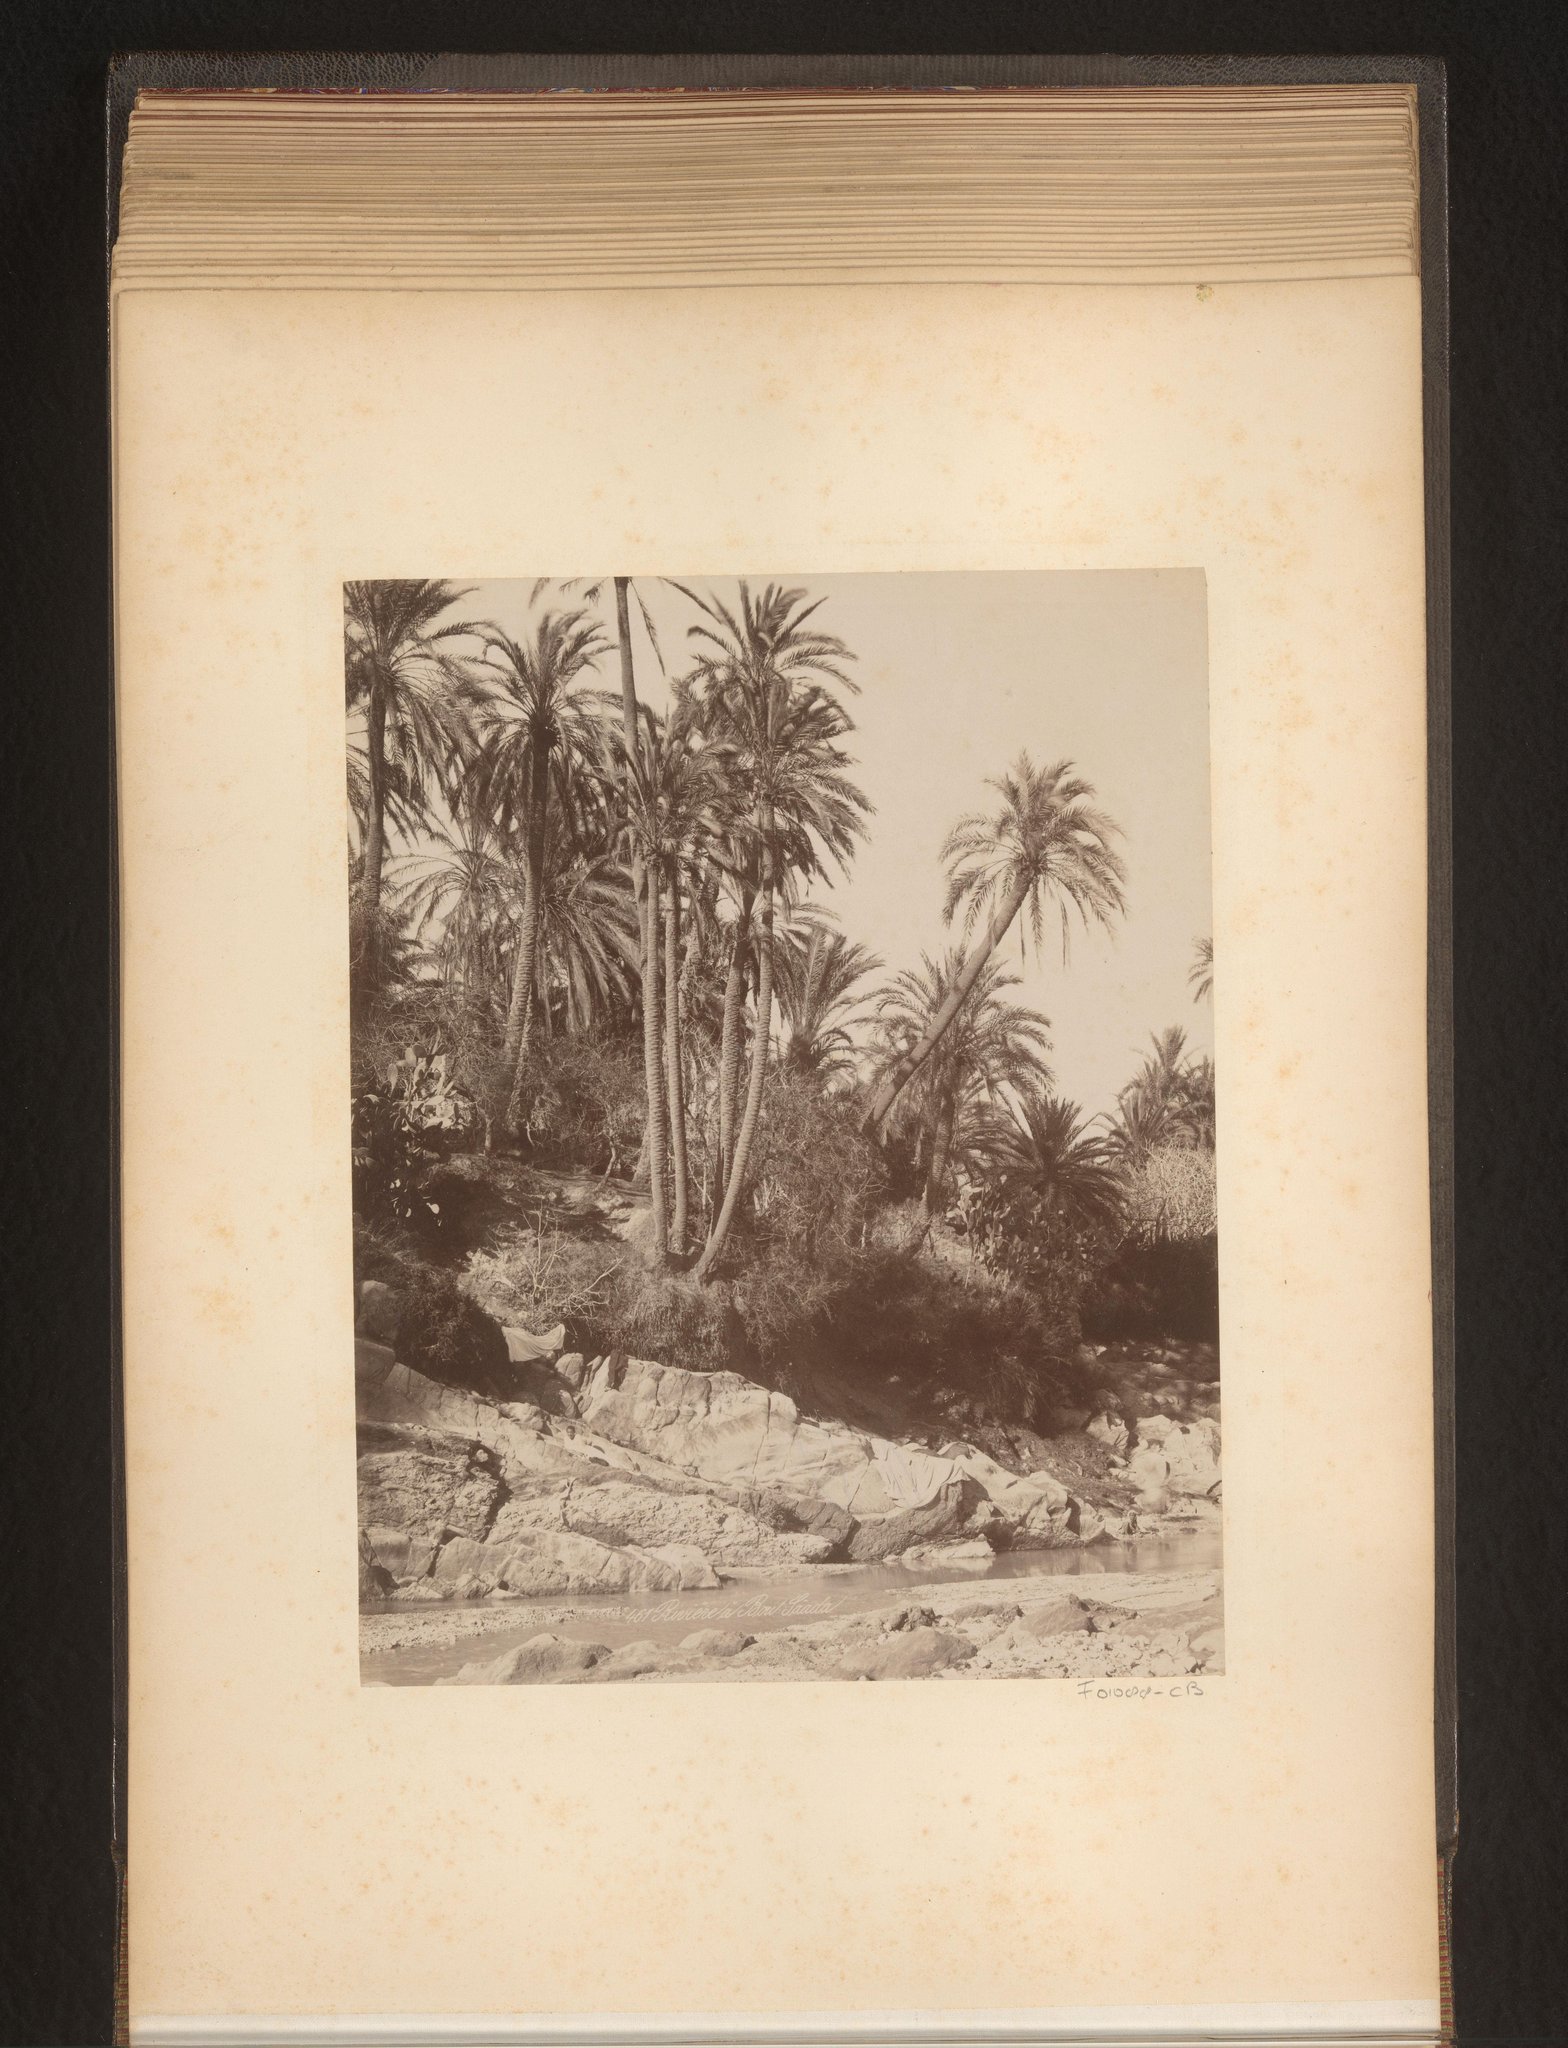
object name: album leaf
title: Rivier met palmbomen langs de kant in de omgeving van Bou Saada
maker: Anonymous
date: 1880-1900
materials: photographic support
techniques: albumen print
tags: river, trees: palm-tree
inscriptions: number: ‘461’